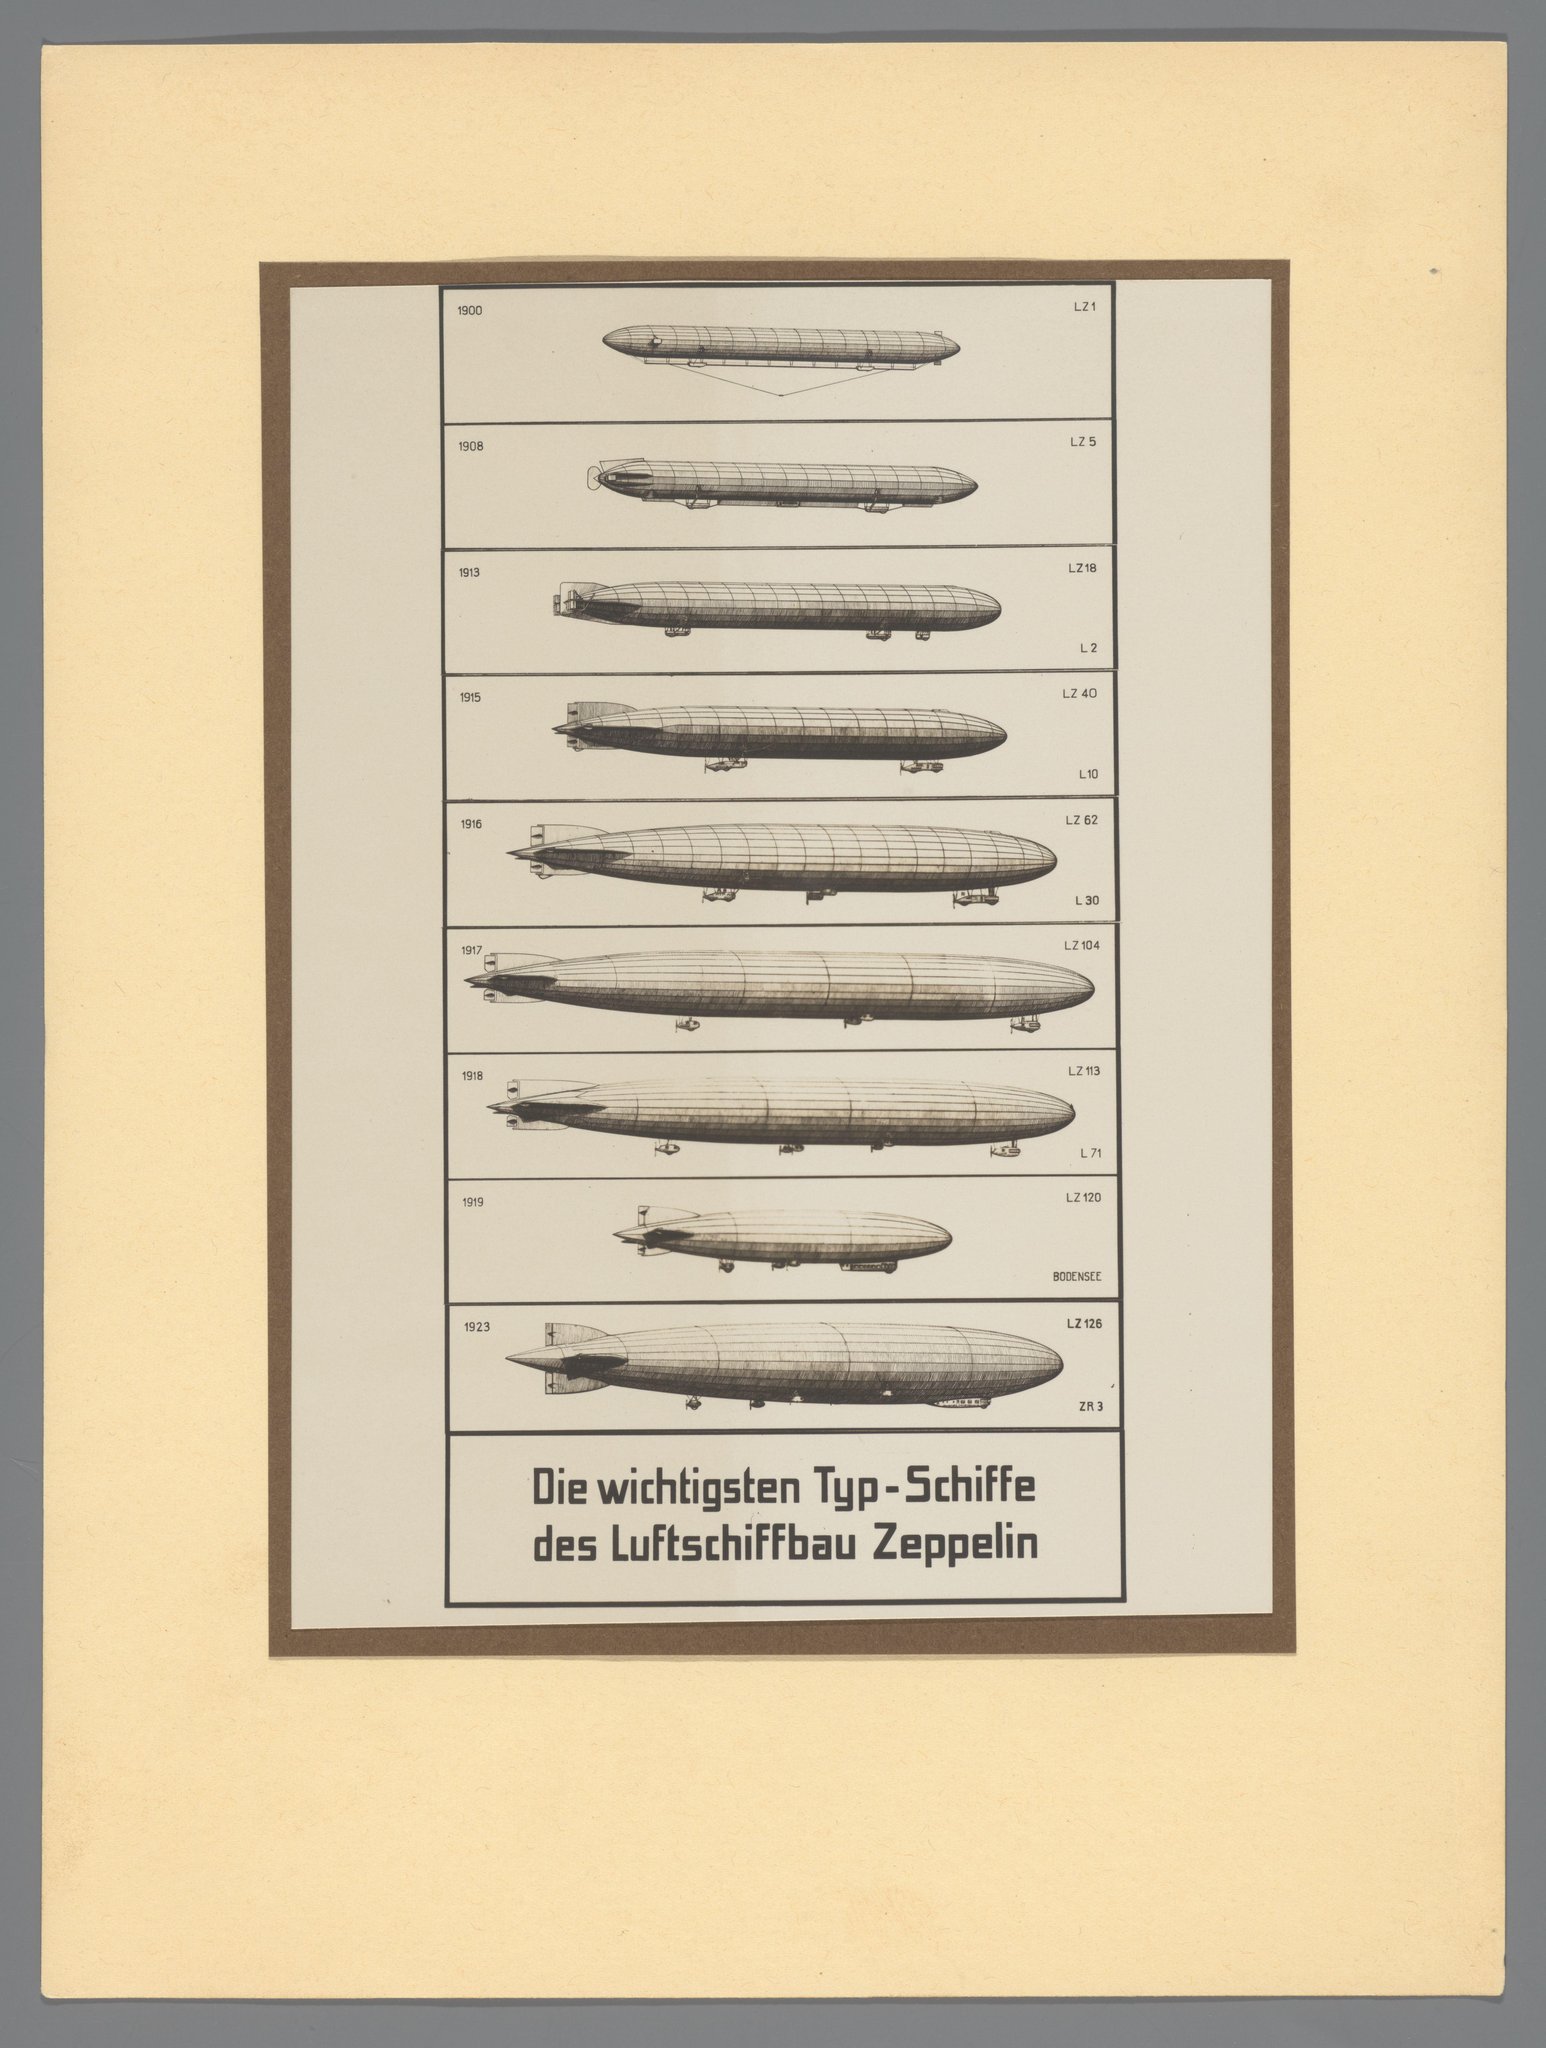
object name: photograph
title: Die wichtigsten Typ-Schiffe des Luftschiffbau Zeppelin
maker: Anonymous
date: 1924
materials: cardboard, photographic support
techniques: gelatin silver print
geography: germany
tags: 46c35 airship, zeppelin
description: Schema van de verschillende typen zeppelins. Onderdeel van een map twintig productfoto's van het Zeppelinluchtschip LZ 126.